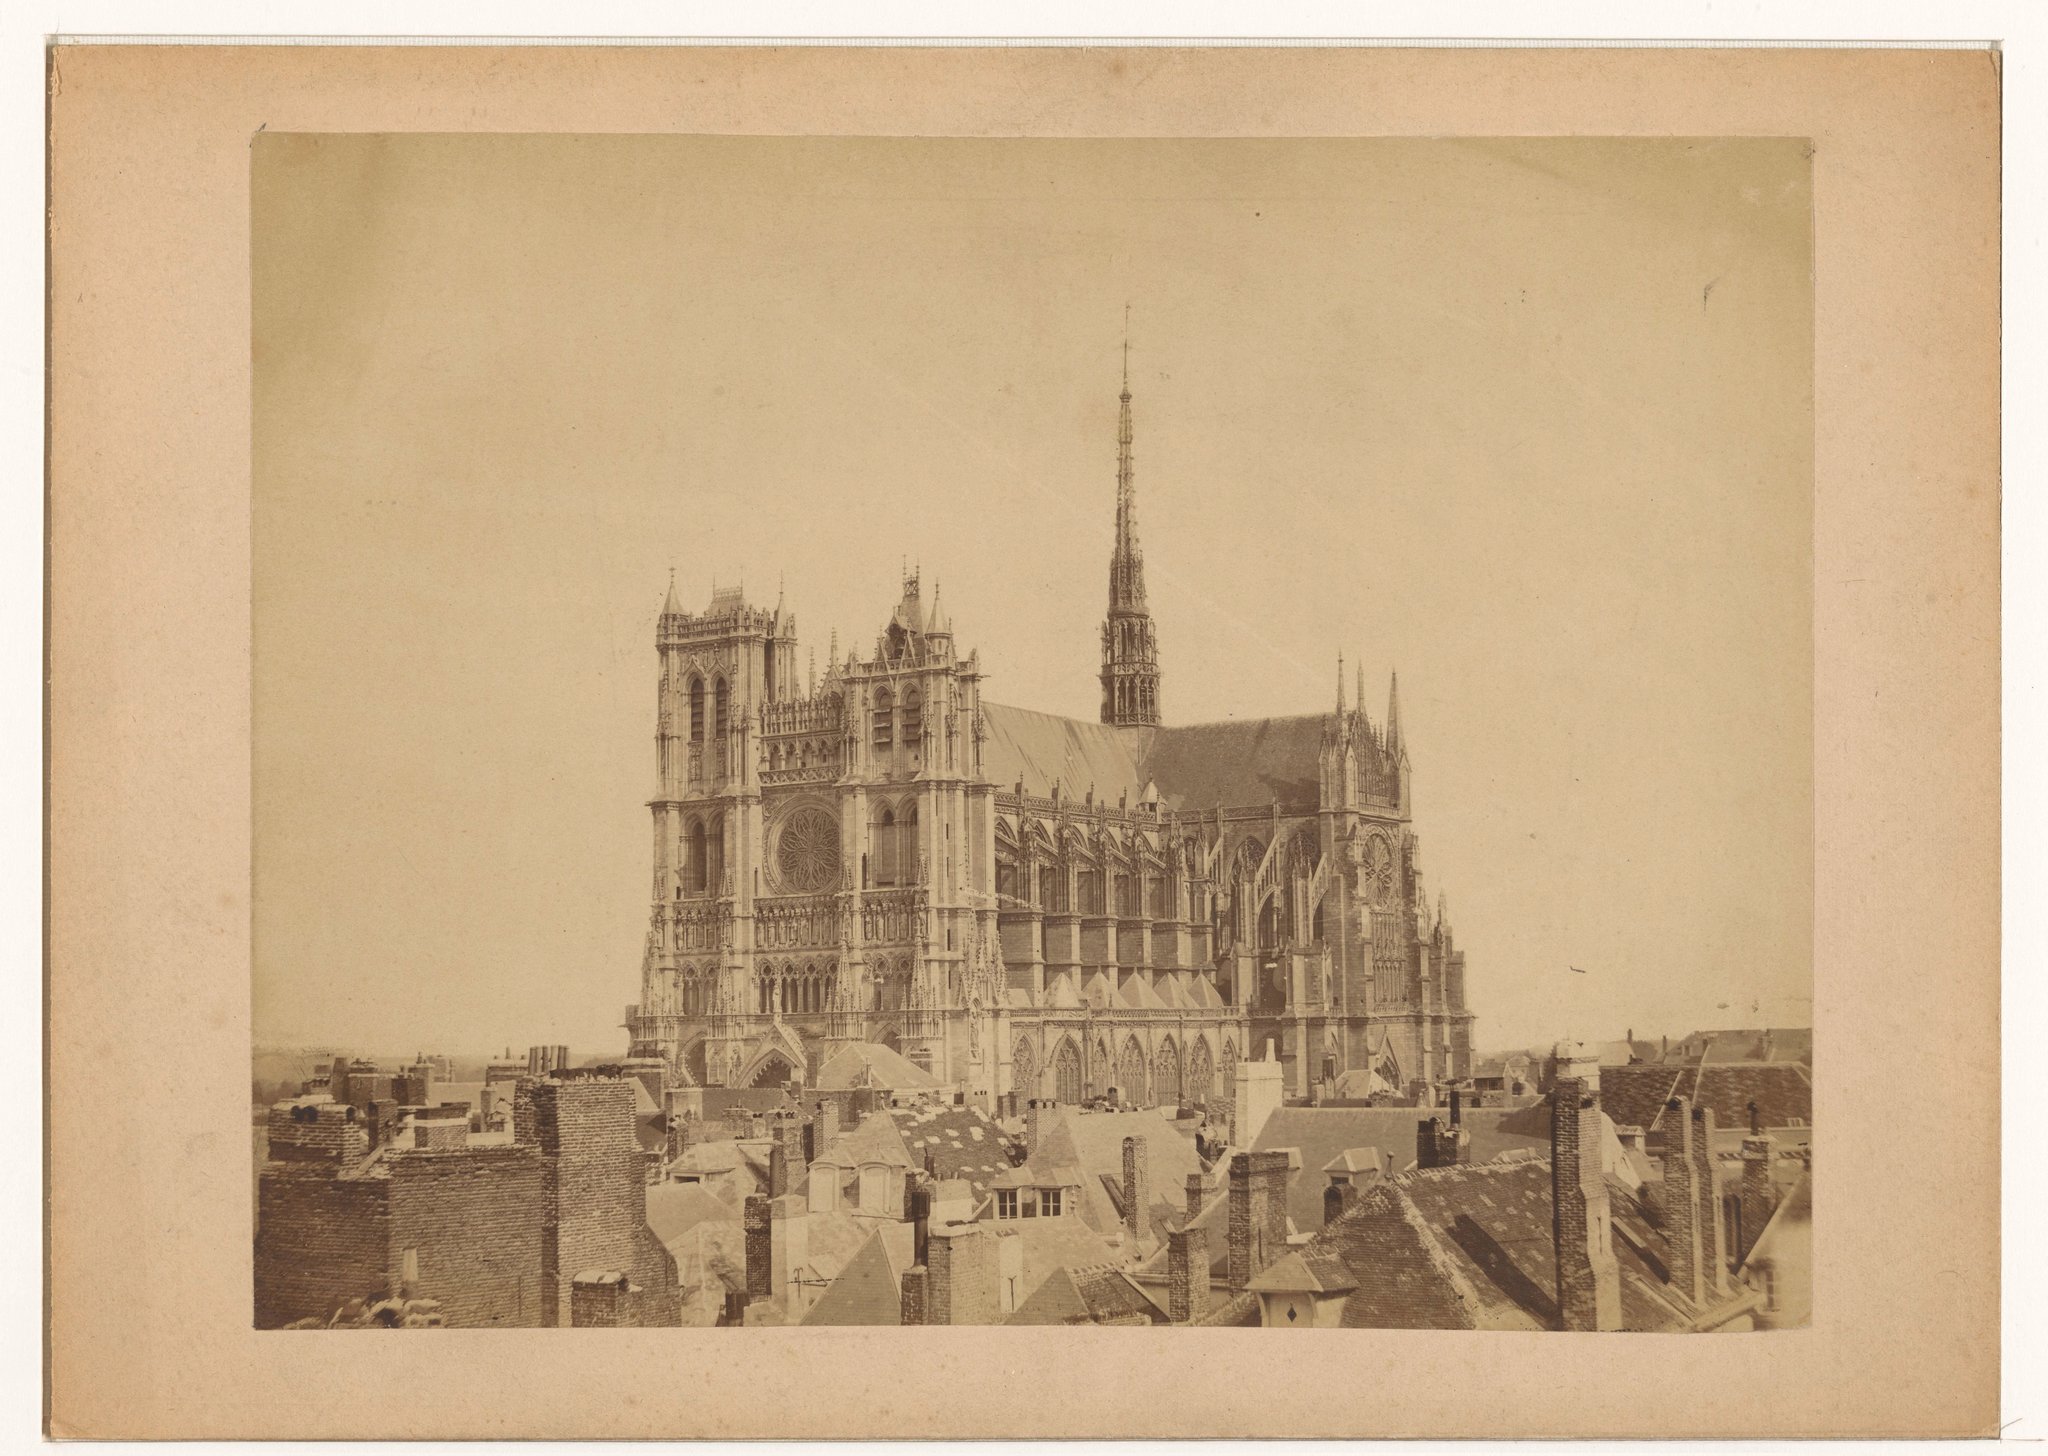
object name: photograph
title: Gezicht op de Notre-Dame van Amiens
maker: Anonymous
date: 1850-1900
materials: cardboard, paper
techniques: albumen print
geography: amiens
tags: church (exterior), notre-dame d'amiens